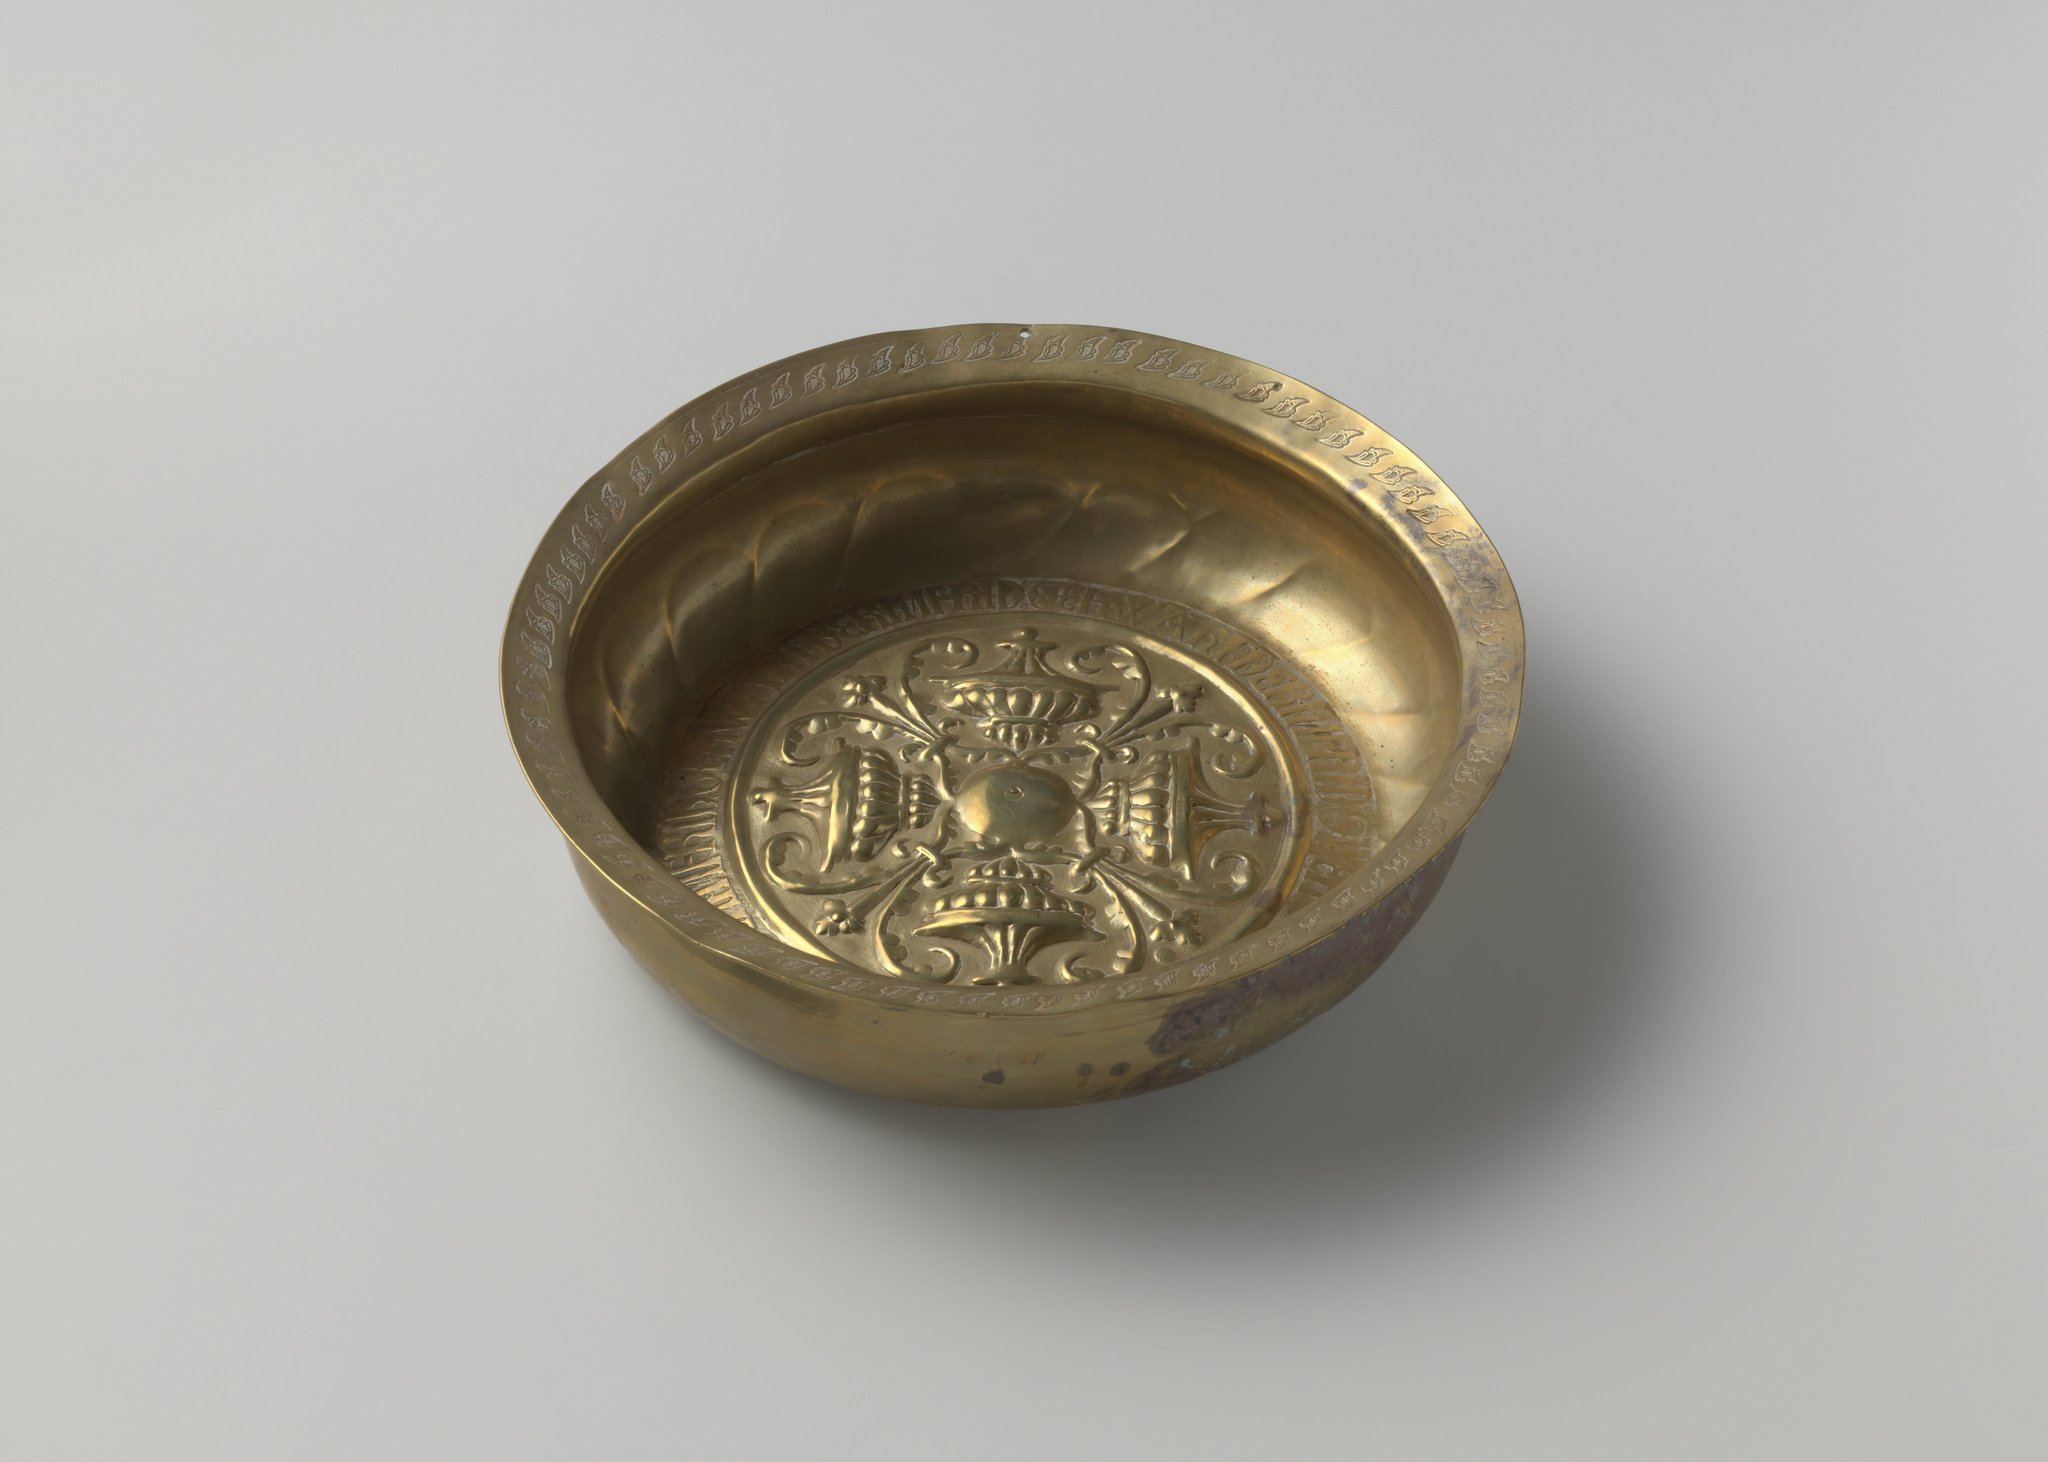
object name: bekken schaal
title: Bekken met renaissancevaas en vegetatief ornament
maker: Anonymous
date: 1500-1550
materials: brass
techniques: casting, metalworking, engraving, punching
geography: nuremberg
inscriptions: inscription: ‘DER IN FRID GWEHWAHRT (een maal)’, inscription: ‘DER IN FRID GEHWAHRT (drie maal)’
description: In het plat van de schotel, die in het midden het centerpunt heeft, zijn met behulp van stempels vormen geponst: een met knorren versierde renaissancevaas met deksel en een gestileerd vegetatief ornament (vier maal herhaald) en het op gearceerde achtergrond aangebrachte opschrift DER IN FRID GEHWAHRT (vier maal herhaald). In de wand van het bekken zijn visblazen gedreven. Op de boord is rondom een geponst ornament aangebracht, met als motief een gestileerd blad. De hangring aan de achterzijde en het gat in de rand zijn later aangebracht.